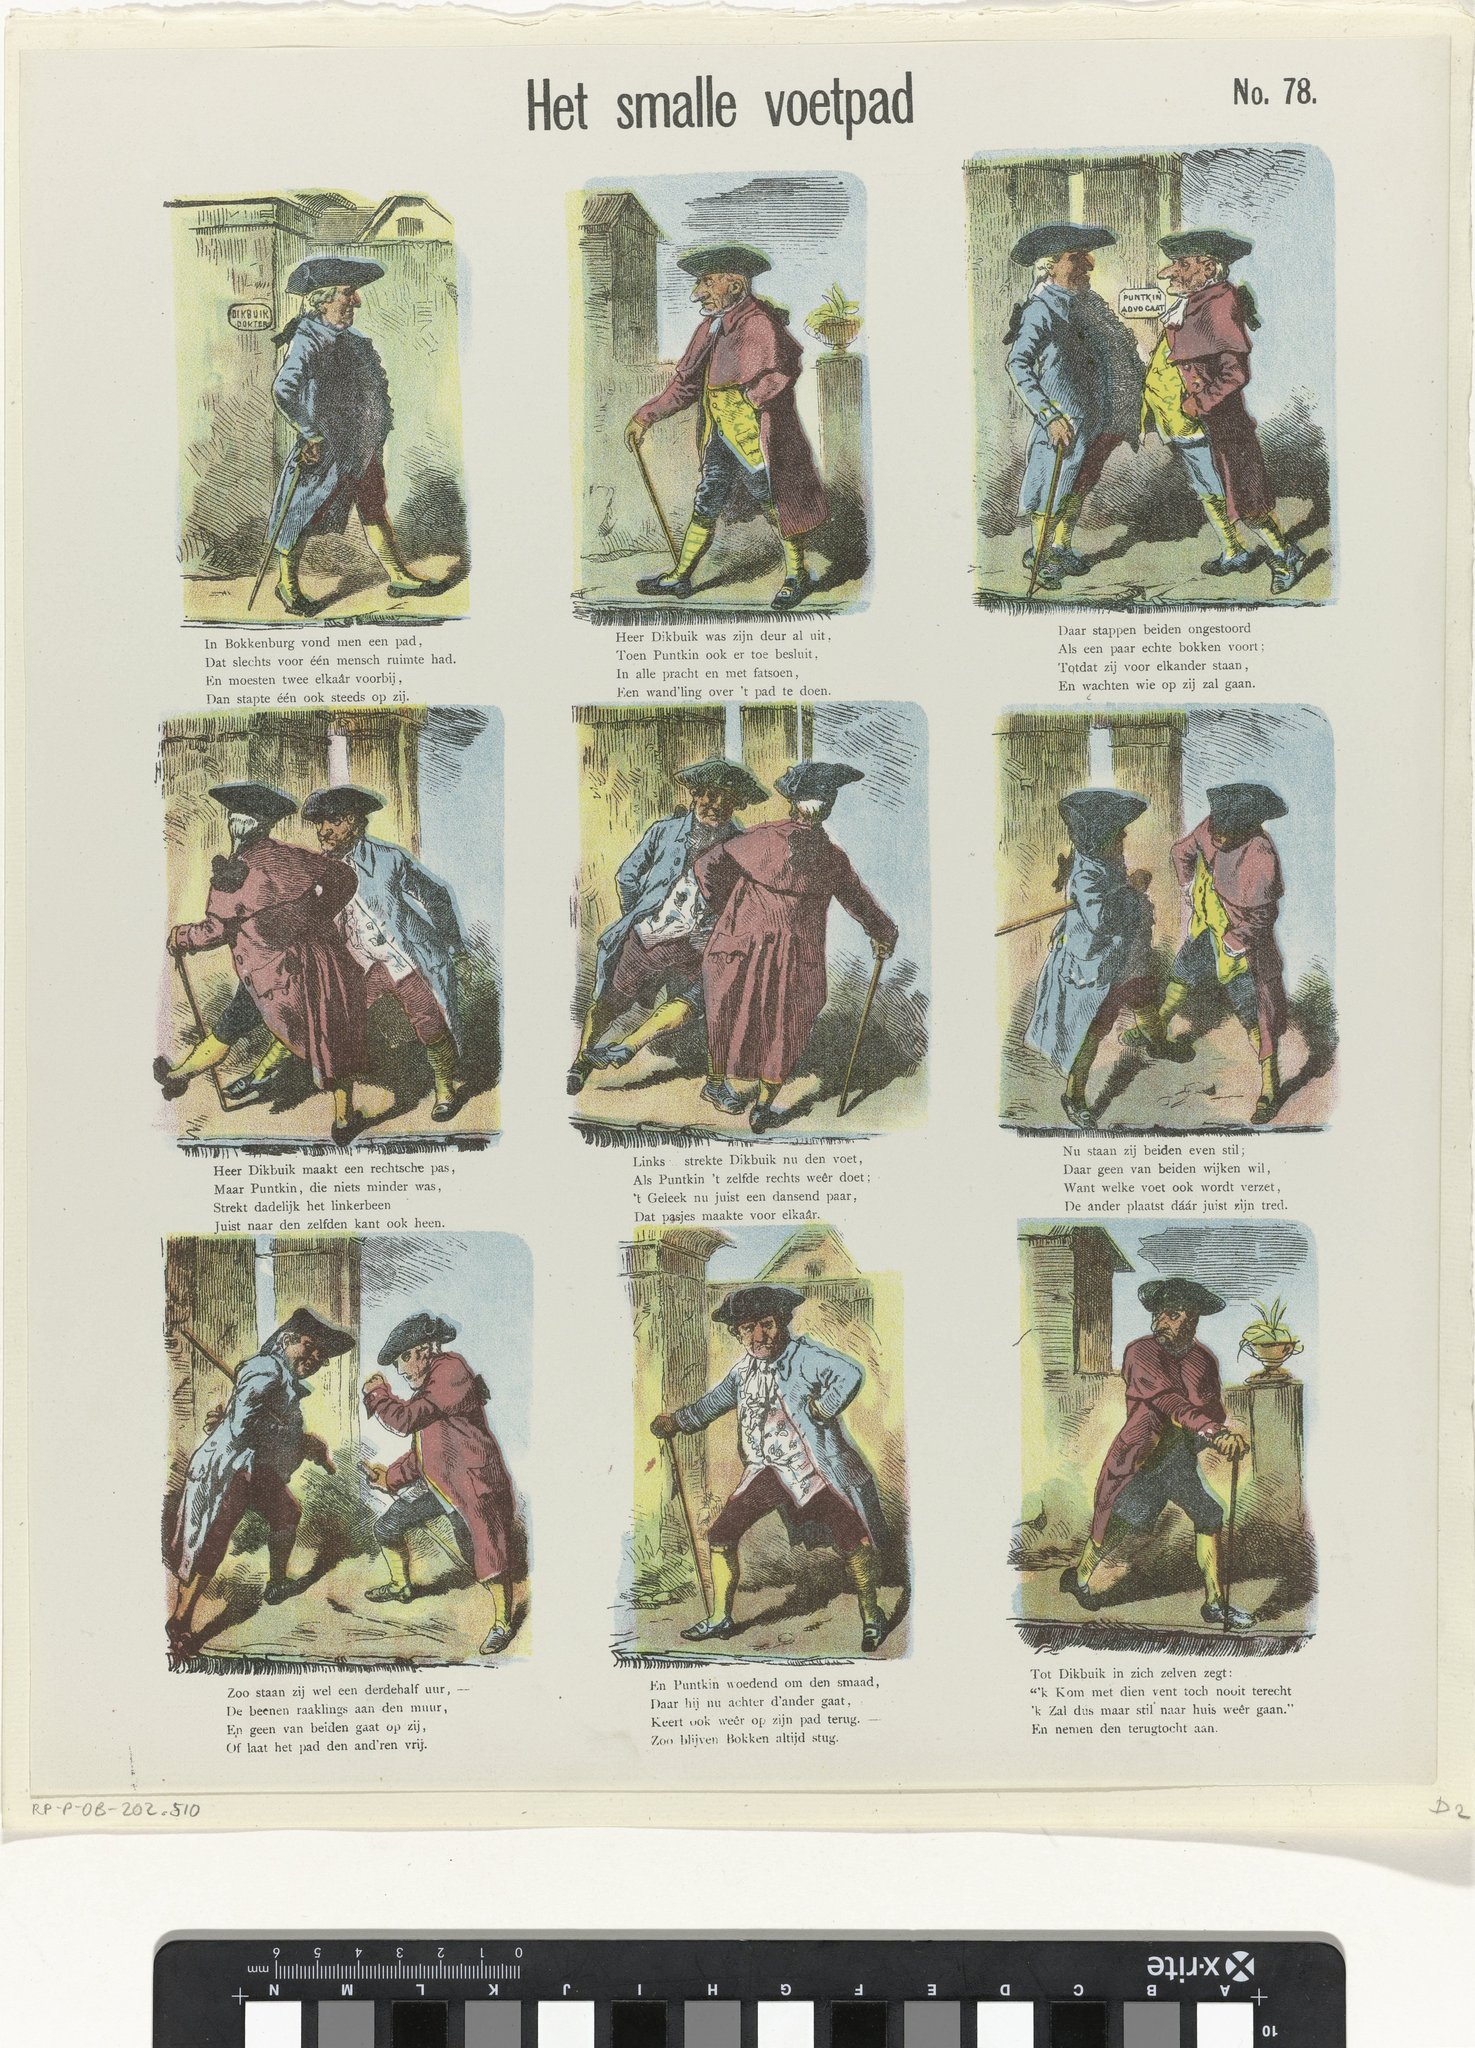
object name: print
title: Het smalle voetpad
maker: Anonymous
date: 1881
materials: paper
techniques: lithograph, letterpress printing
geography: amsterdam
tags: fat (human type), comedy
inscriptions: collector's mark: Lugt 2760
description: Blad met 9 voorstellingen over twee mannen, dokter Dikbuik en advocaat Puntkin, die niet door een smalle steeg kunnen. Onder elke afbeelding een vierregelig vers. Genummerd rechtsboven: No. 78.